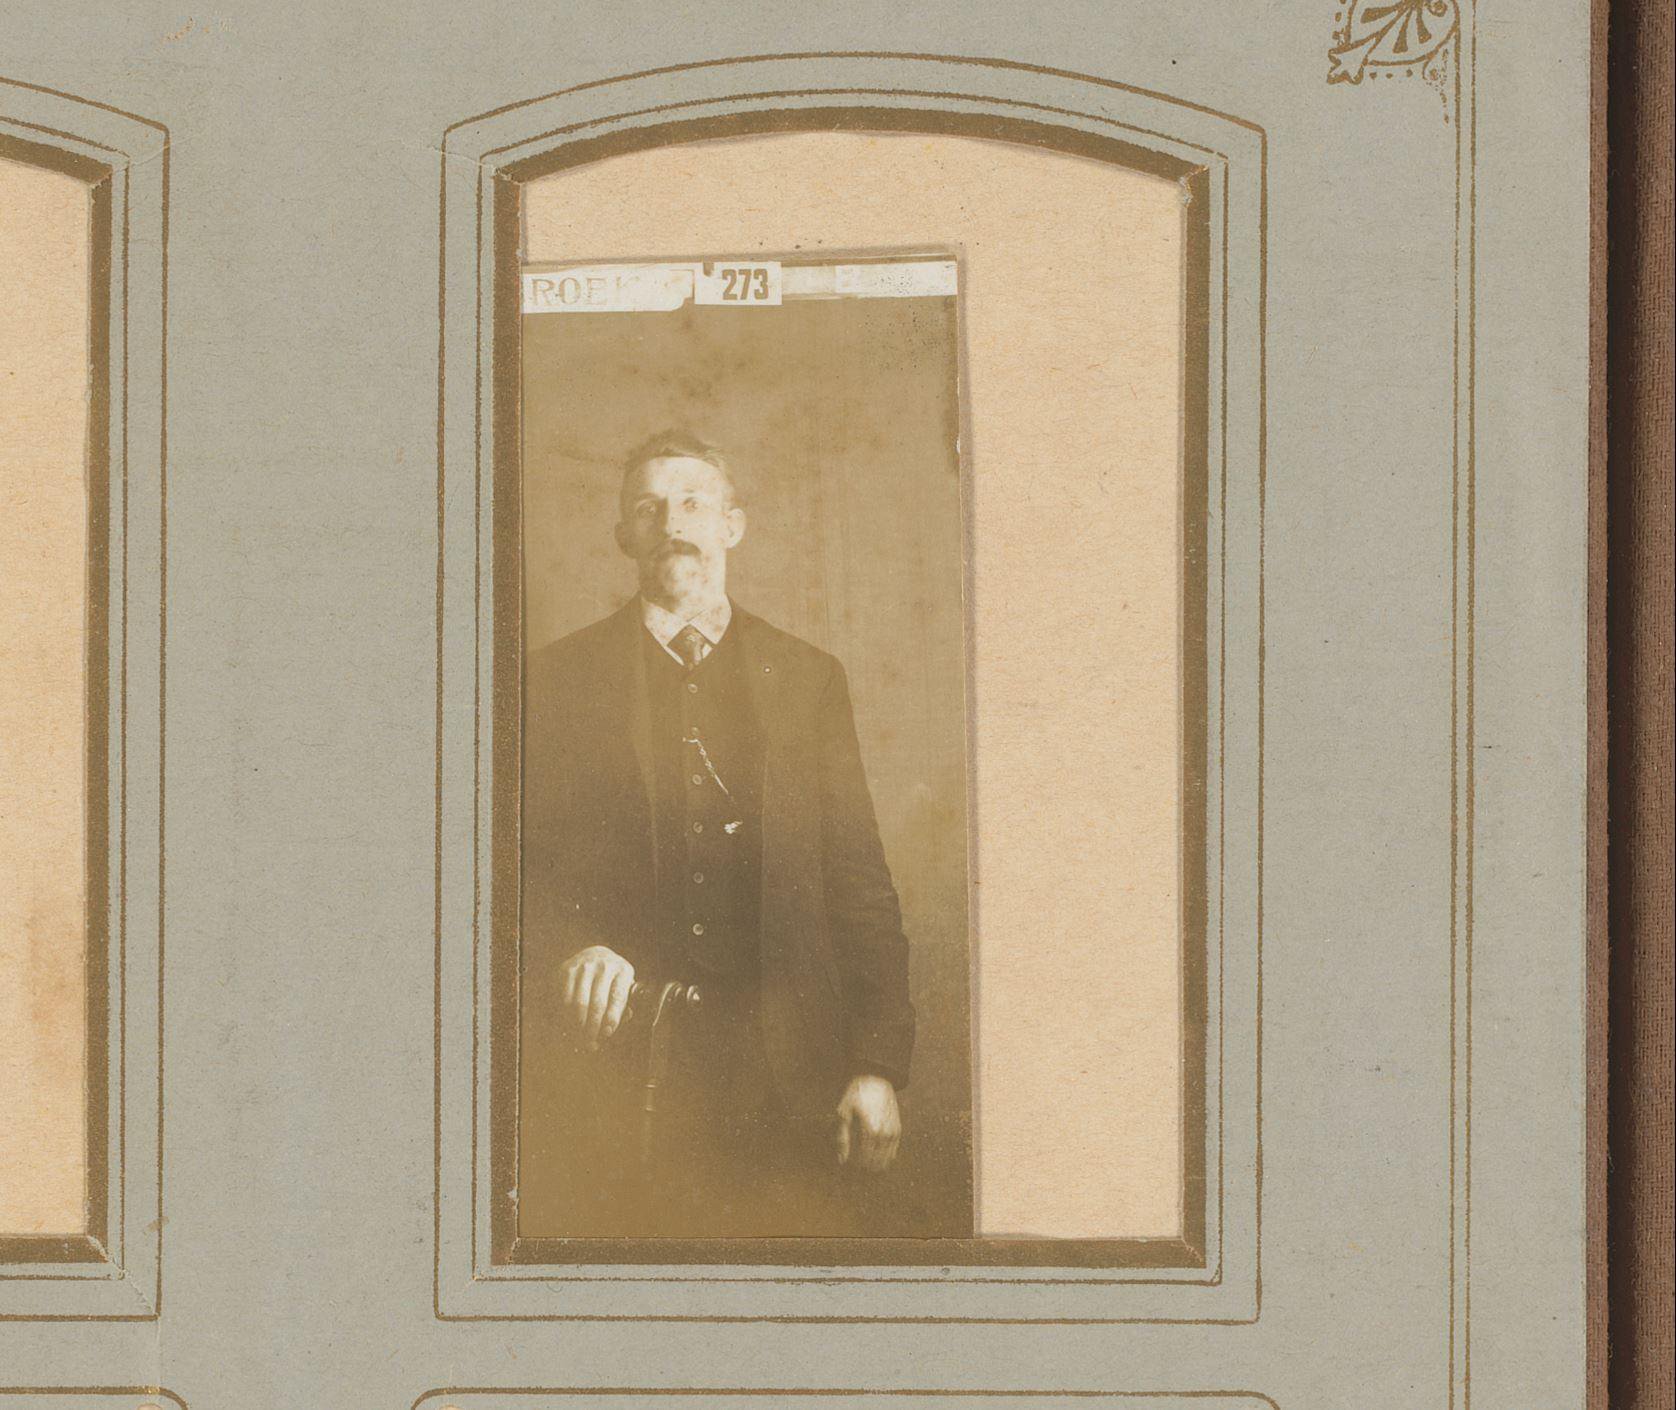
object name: photograph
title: Portret van een man, staand bij een stoel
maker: broek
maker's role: fotograaf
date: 1900-1930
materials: photographic support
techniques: gelatin silver print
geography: netherlands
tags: historical persons, chair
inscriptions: inscription: ‘BROEK 273’